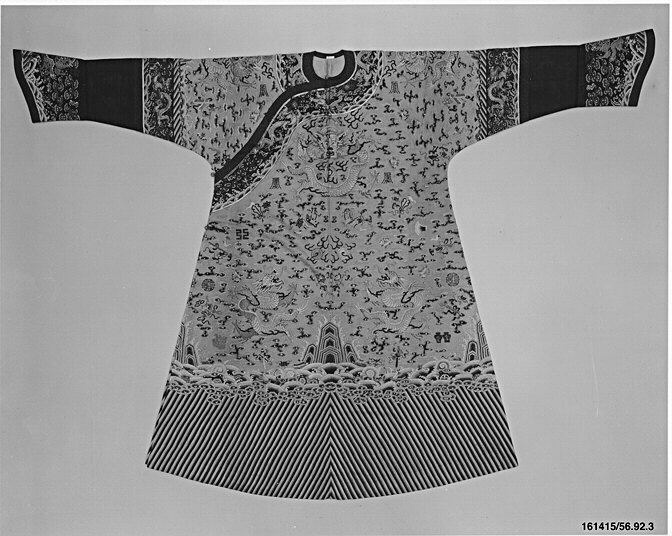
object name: robe, emperor's 12 symbol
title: Empress's Twelve-Symbol Robe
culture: chinese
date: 1851-1861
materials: silk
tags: dragons